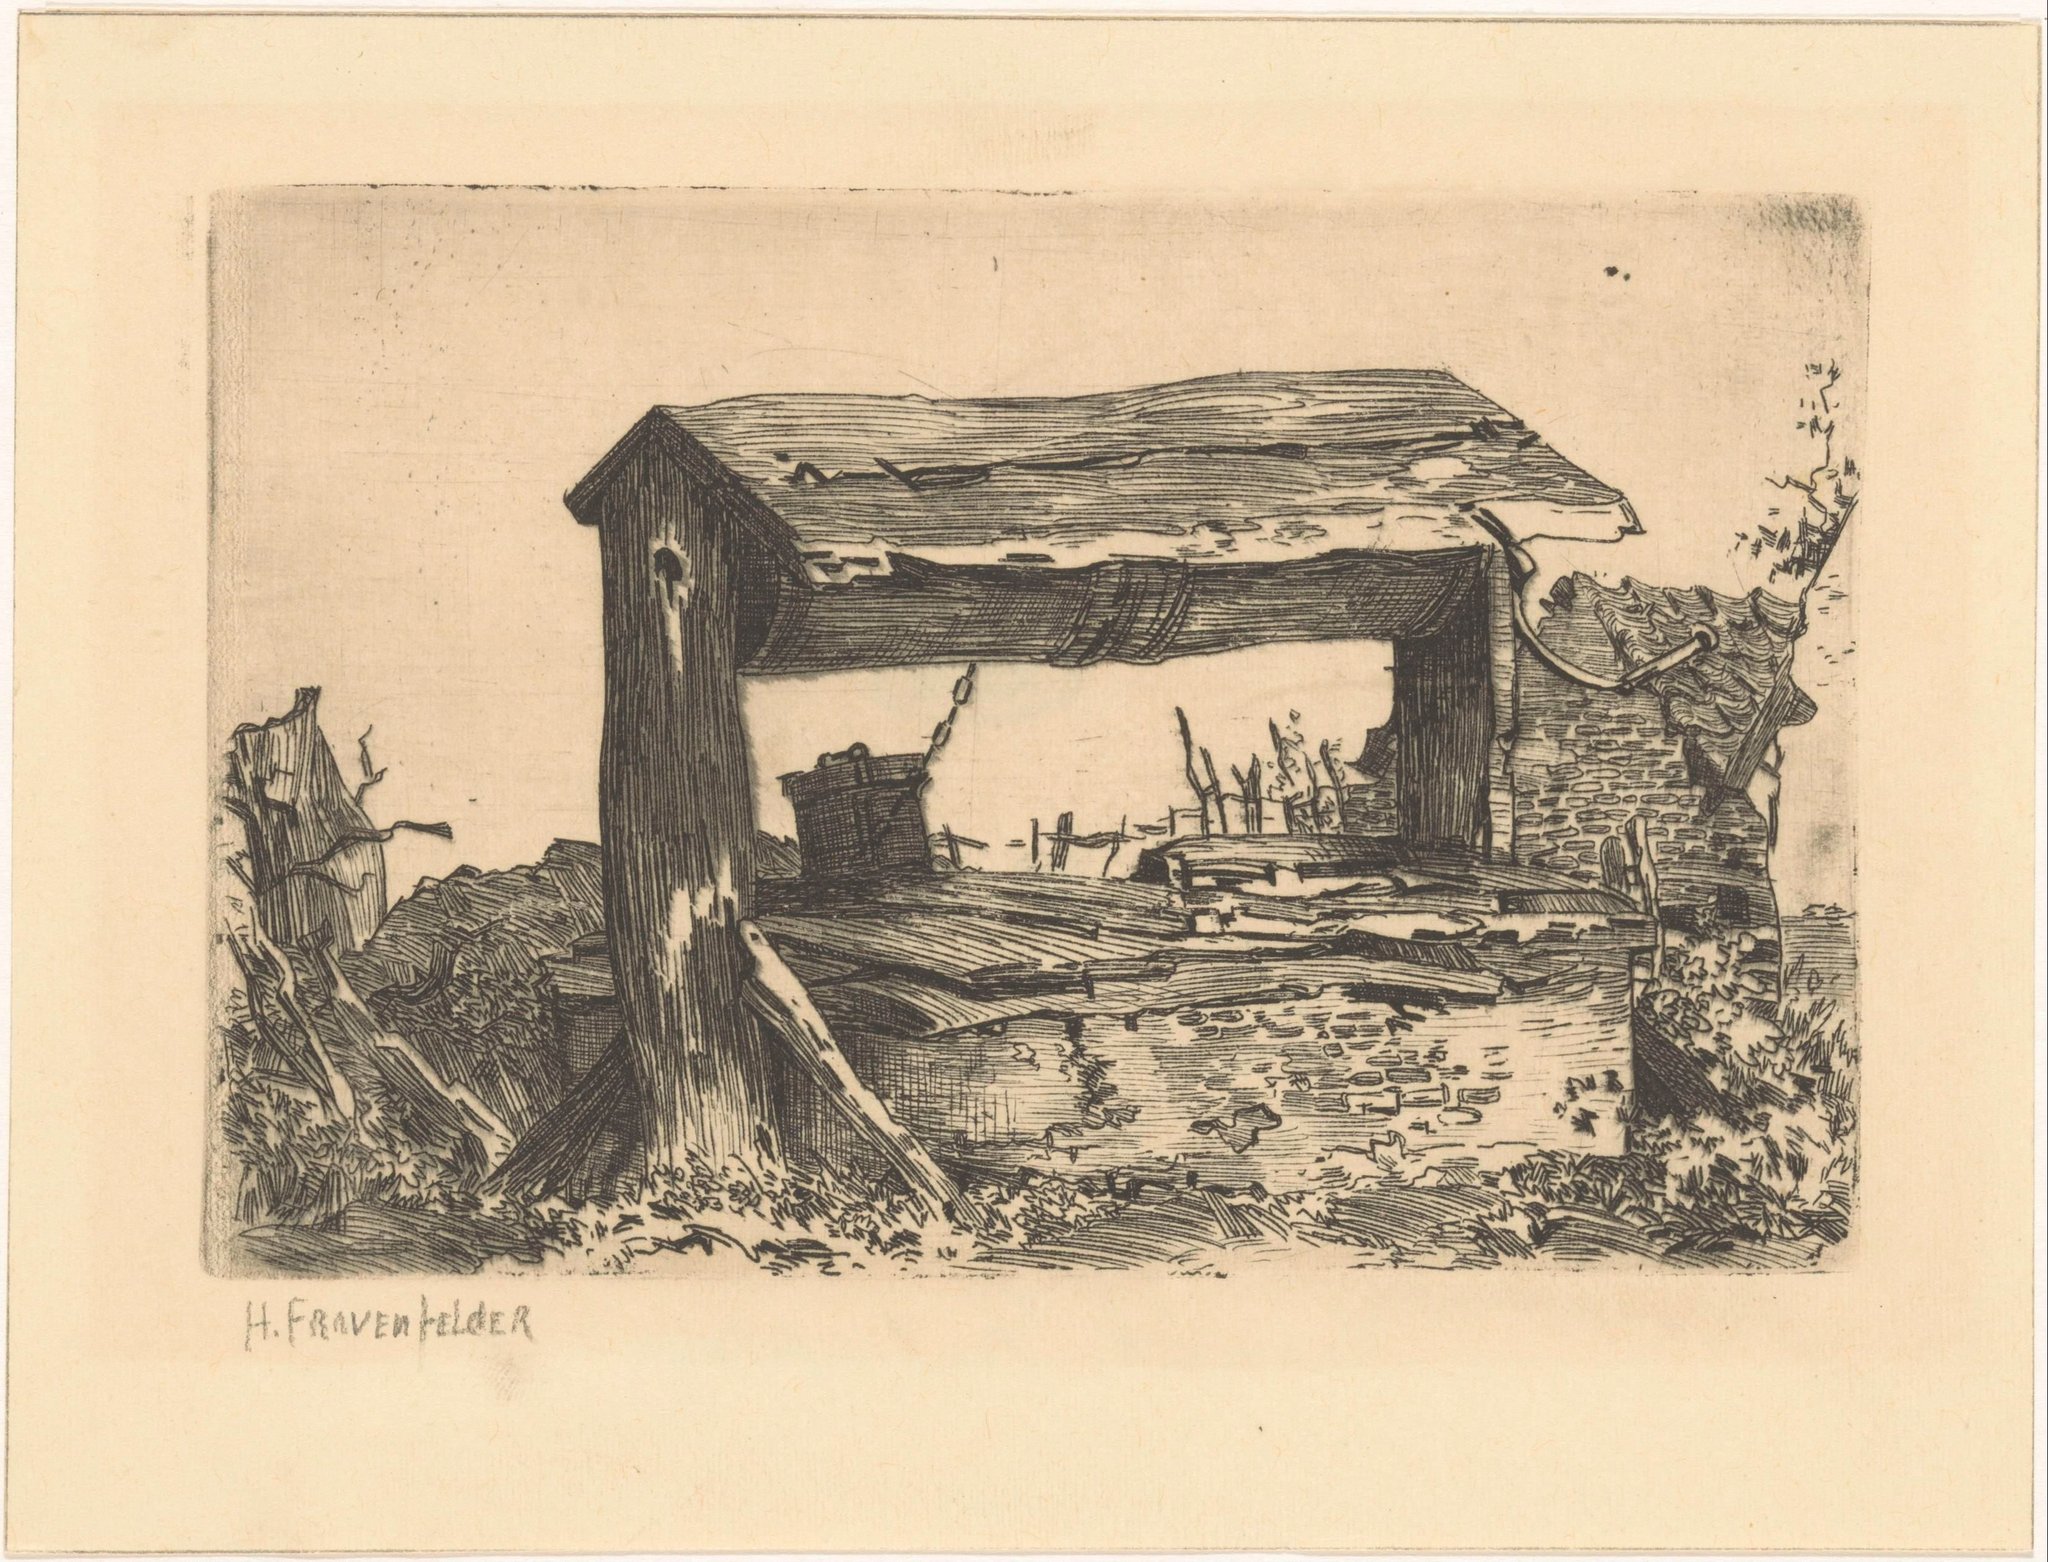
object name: print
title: Waterput met afdak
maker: hendrik frauenfelder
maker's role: print maker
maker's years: 1885-1922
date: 1895-1922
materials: paper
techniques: etching, intaglio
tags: well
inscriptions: collector's mark: Lugt 2760, collector's mark: Lugt 2228